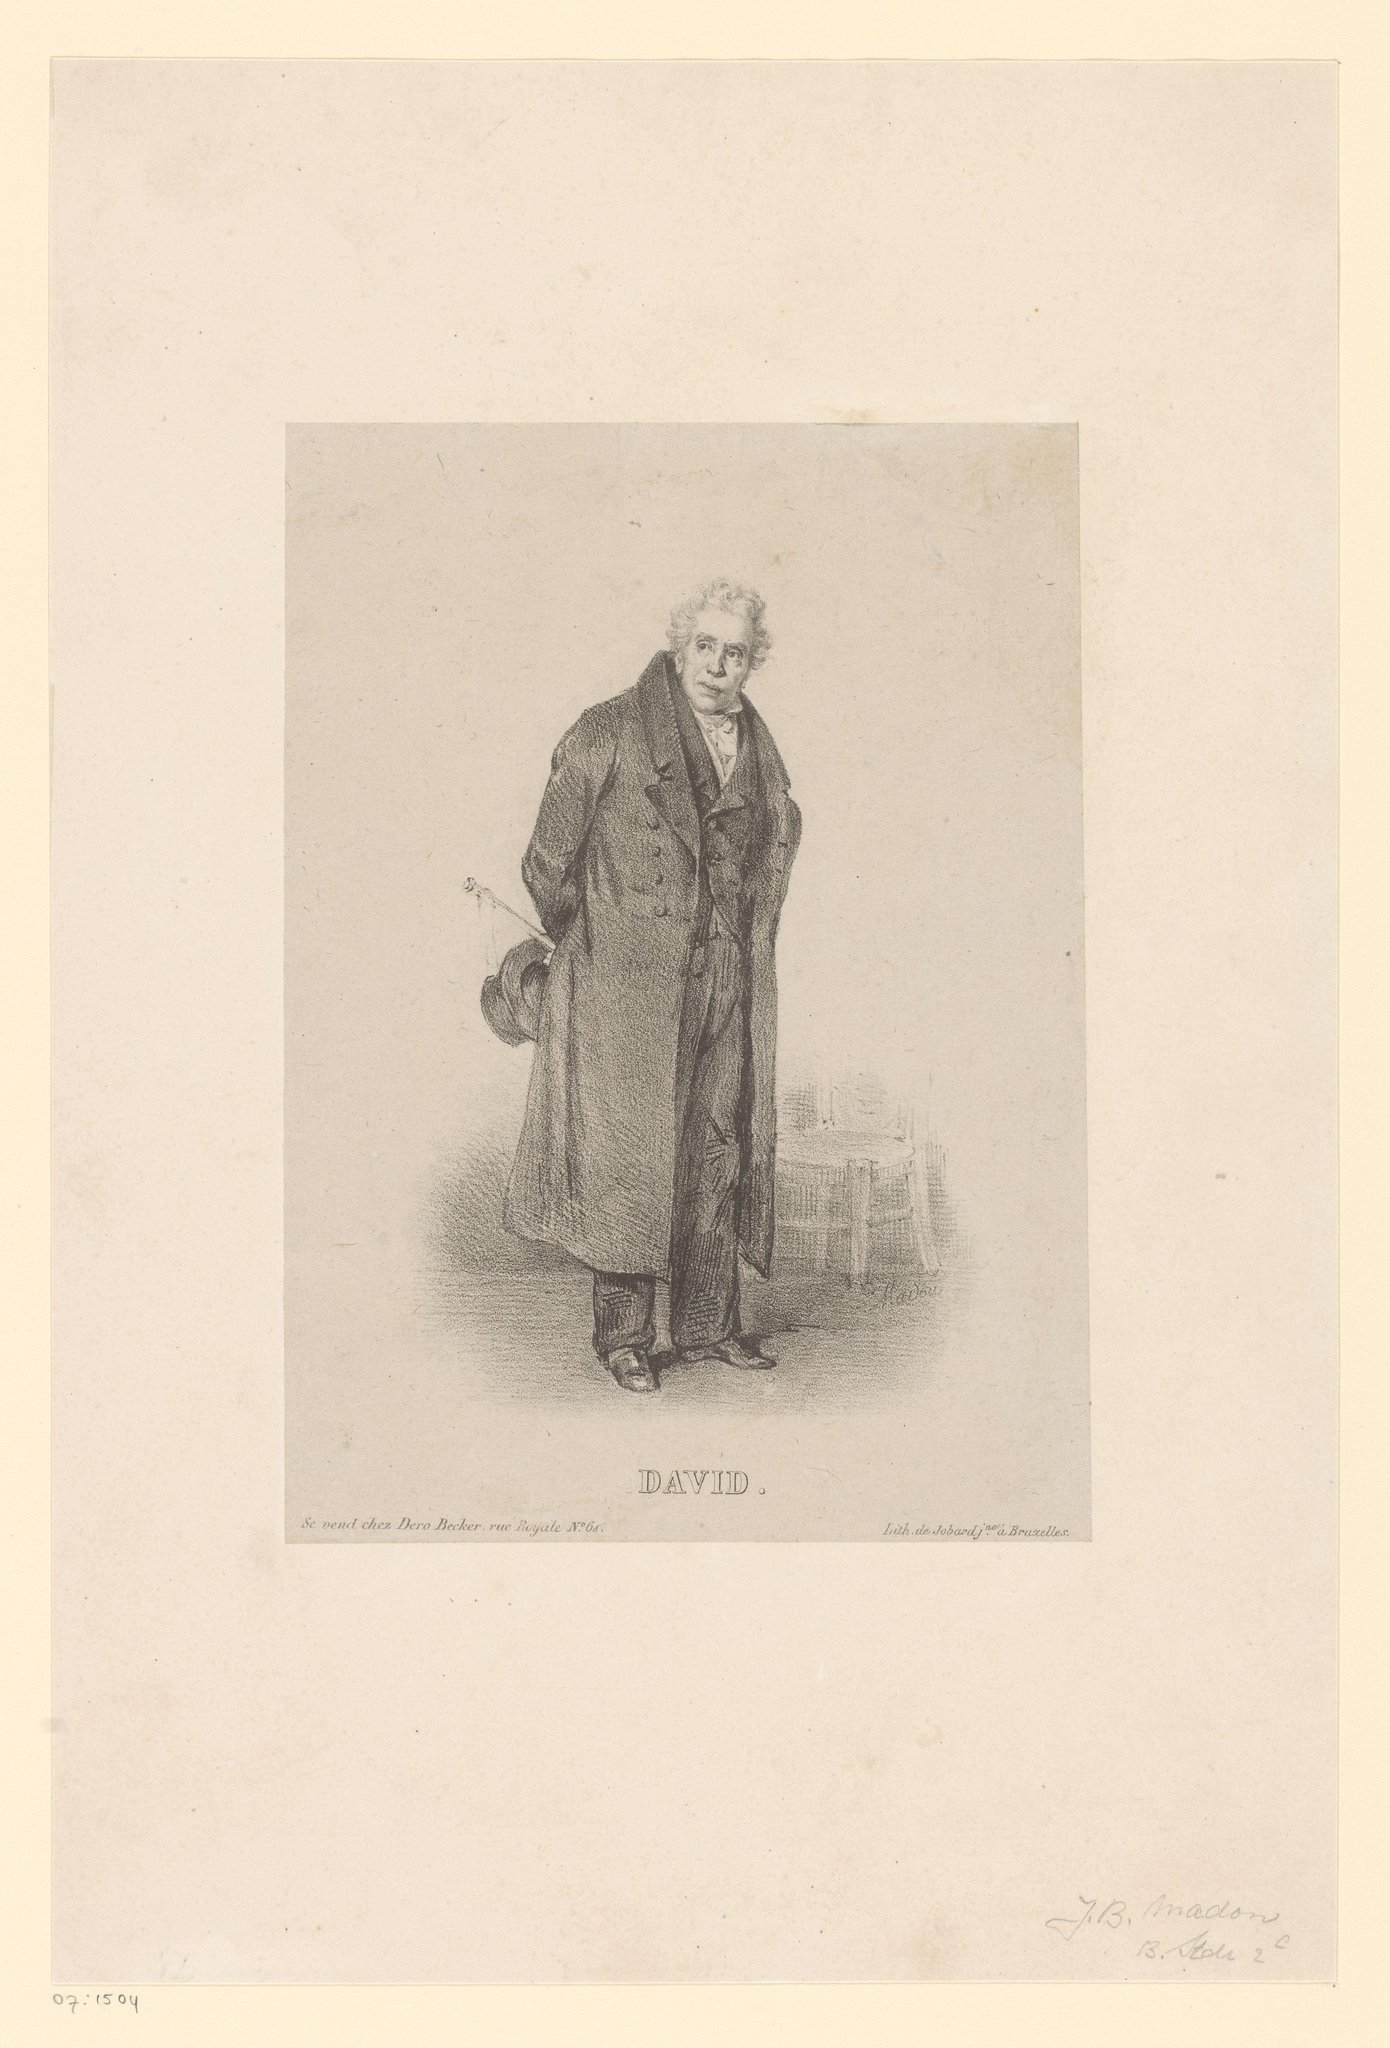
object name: print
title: Nimf met een kroon van madeliefjes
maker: maurice denis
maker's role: print maker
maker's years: 1870-1943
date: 1899-1901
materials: paper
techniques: lithograph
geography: france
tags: adolescent, young woman, maiden, taking a bath - aa - in the open air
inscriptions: collector's mark: Lugt 2228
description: Prent gebruikt voor: Germinal. Album de XX estampes originales. Parijs: La Maison Moderne, s.a. [1899 of 1901].